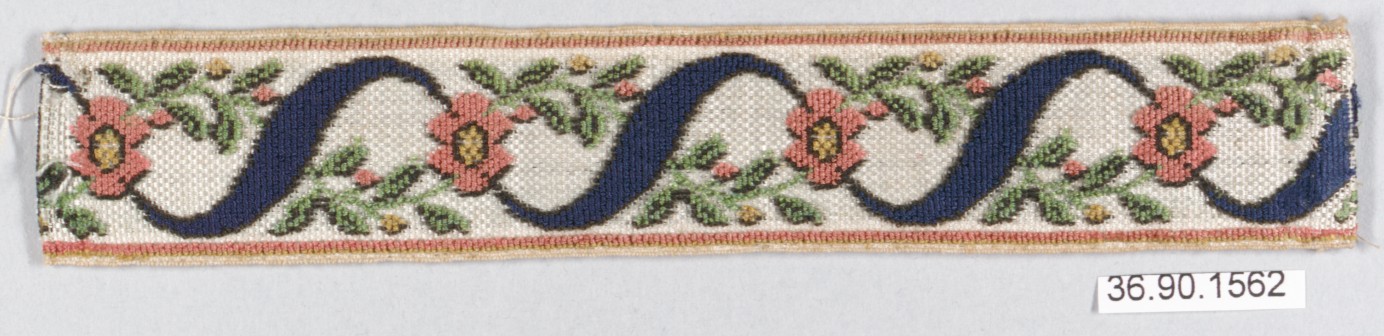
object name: galloon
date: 1701-1900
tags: flowers,leaves